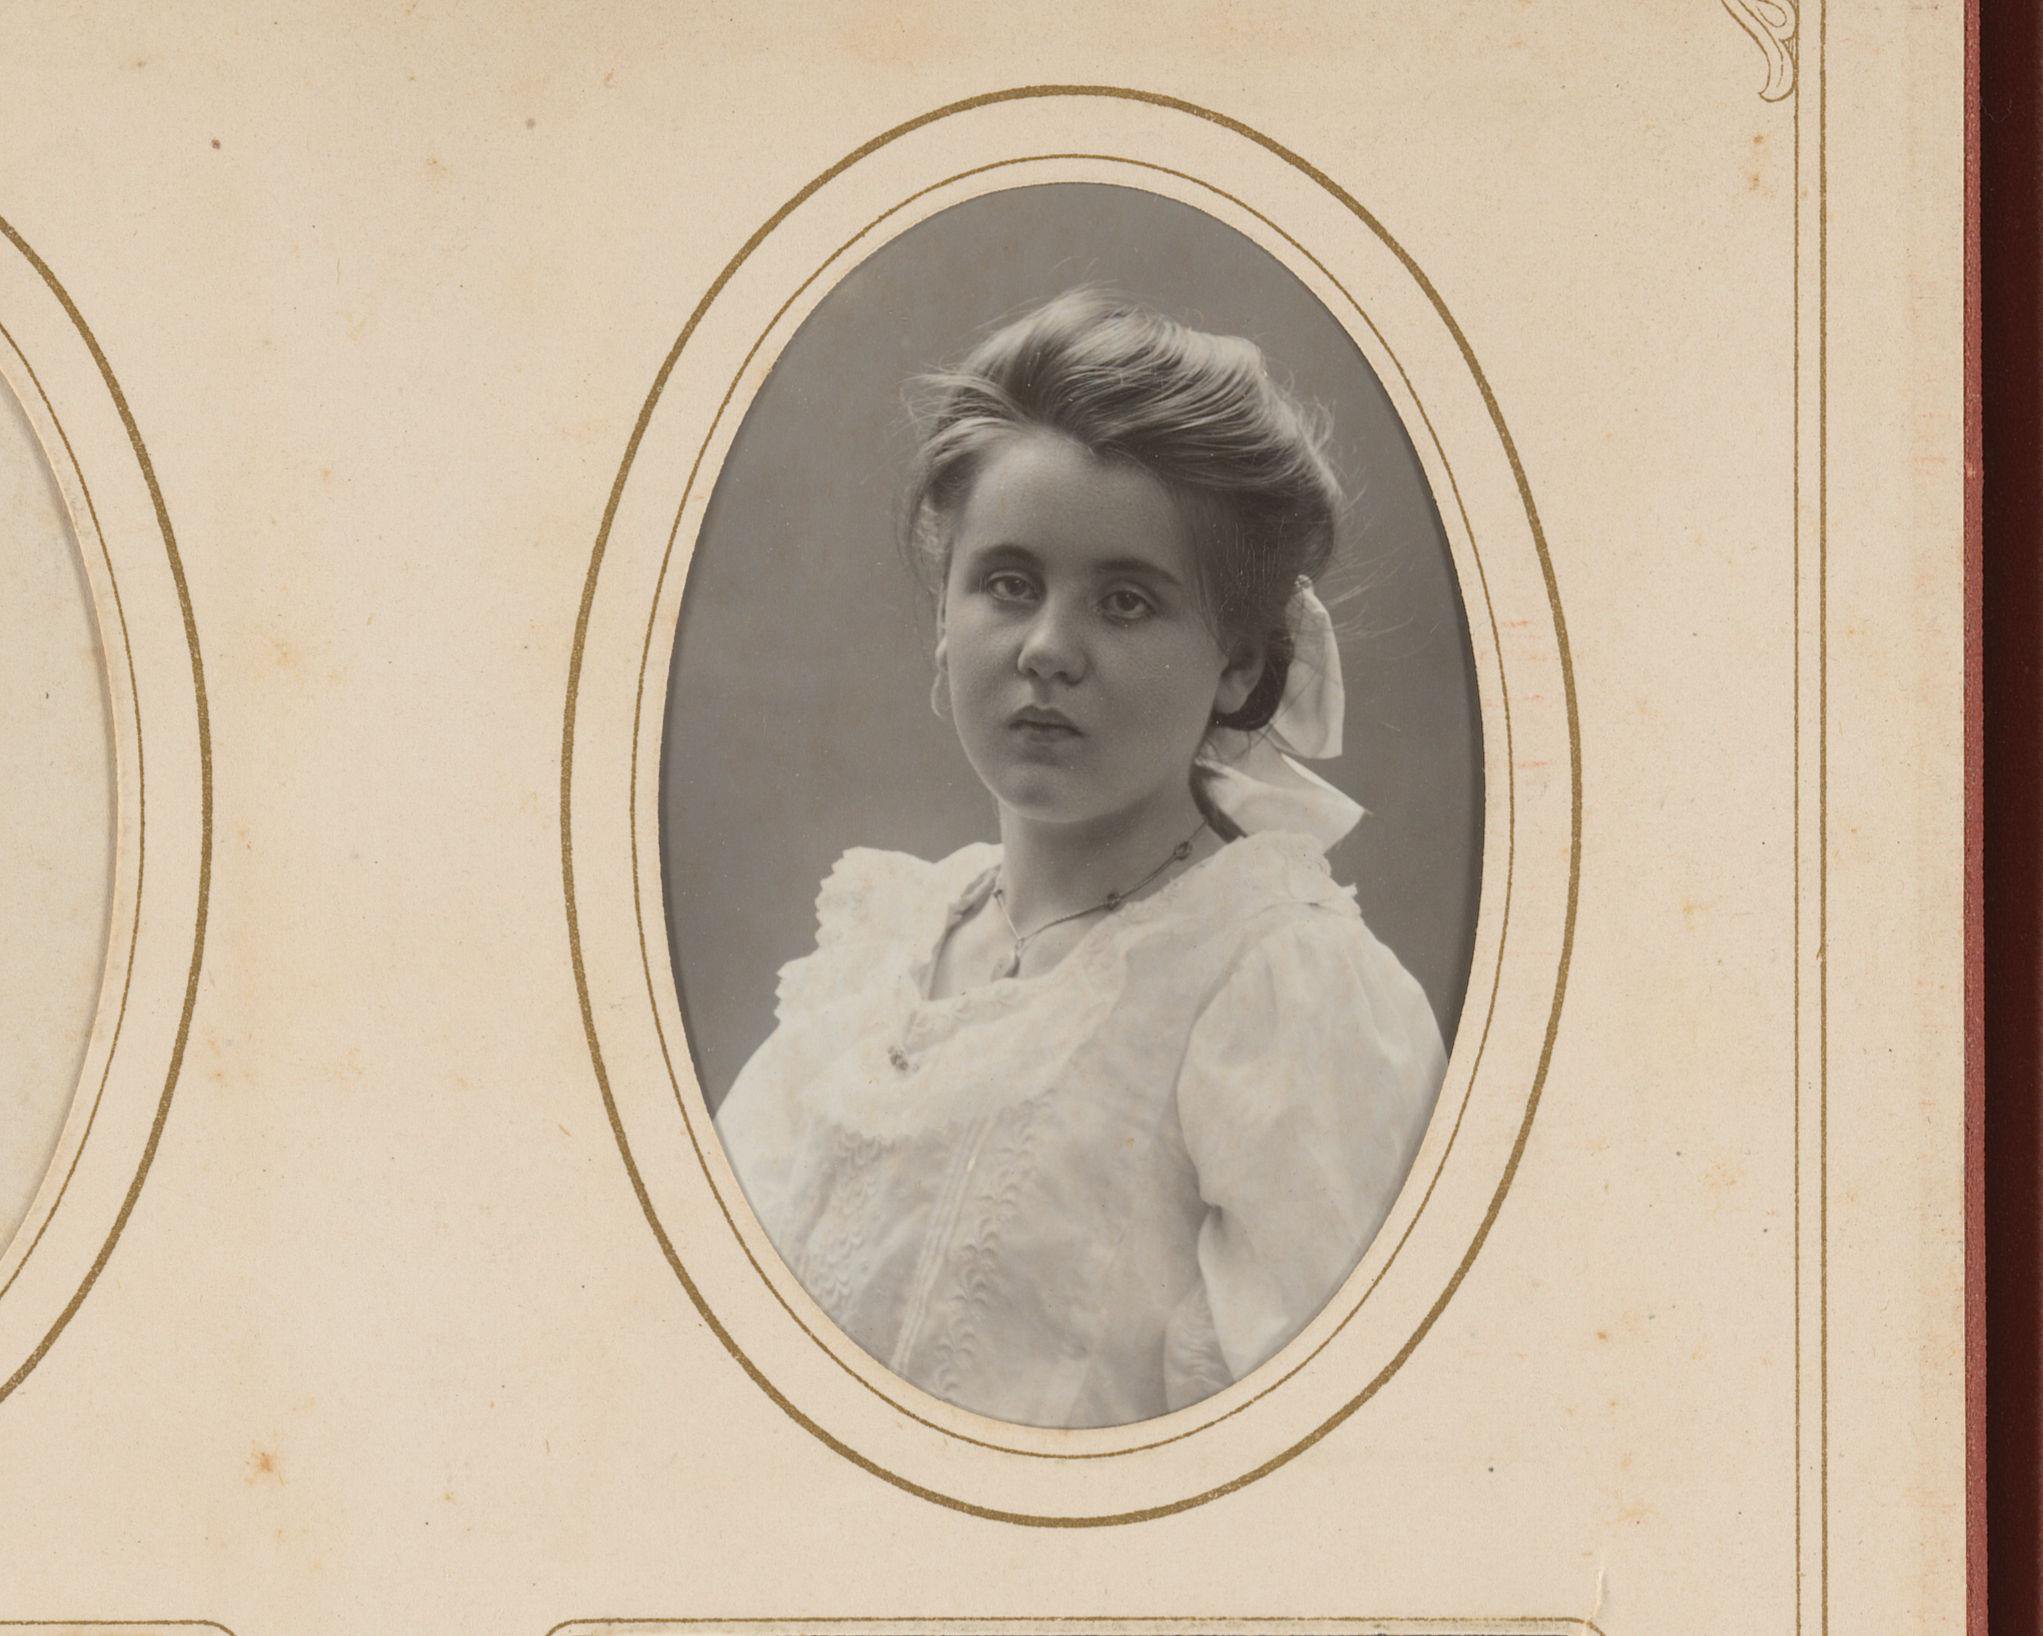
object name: photograph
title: Portret van een jonge vrouw, aangeduid als Karla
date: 1895-1920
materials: cardboard, photographic support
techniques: matte daylight collodion silver print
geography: dusseldorf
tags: adolescent, young woman, maiden, historical persons - bb - woman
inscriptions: inscription: ‘Atelier/ Samson & Co/ Düsseldorf/ Schadowstr. 79.’, annotation: ‘zum Andenken/ [..]n [...]/ Karla’, number: ‘8645’